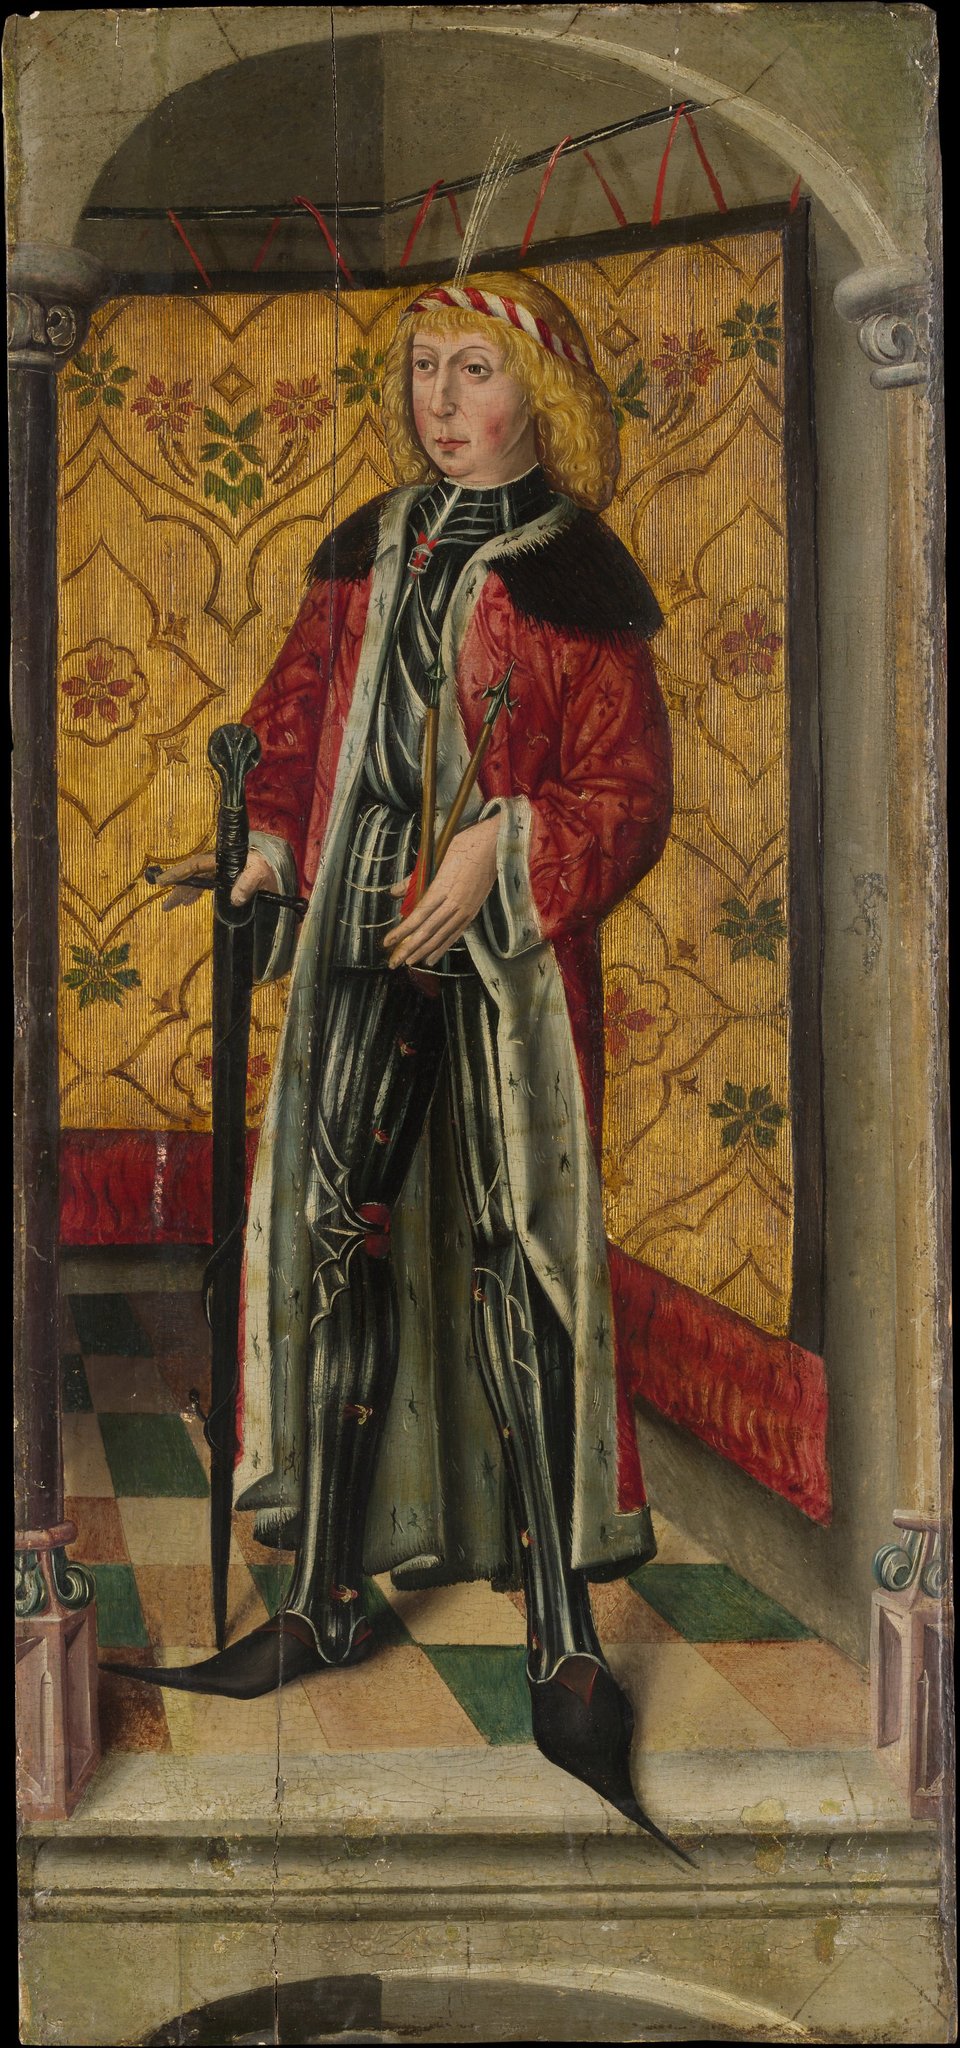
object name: two painted panel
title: Saint George and Saint Sebastian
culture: german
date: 1480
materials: oil, wood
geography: germany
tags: armor,men,dragons,saint george,saint sebastian